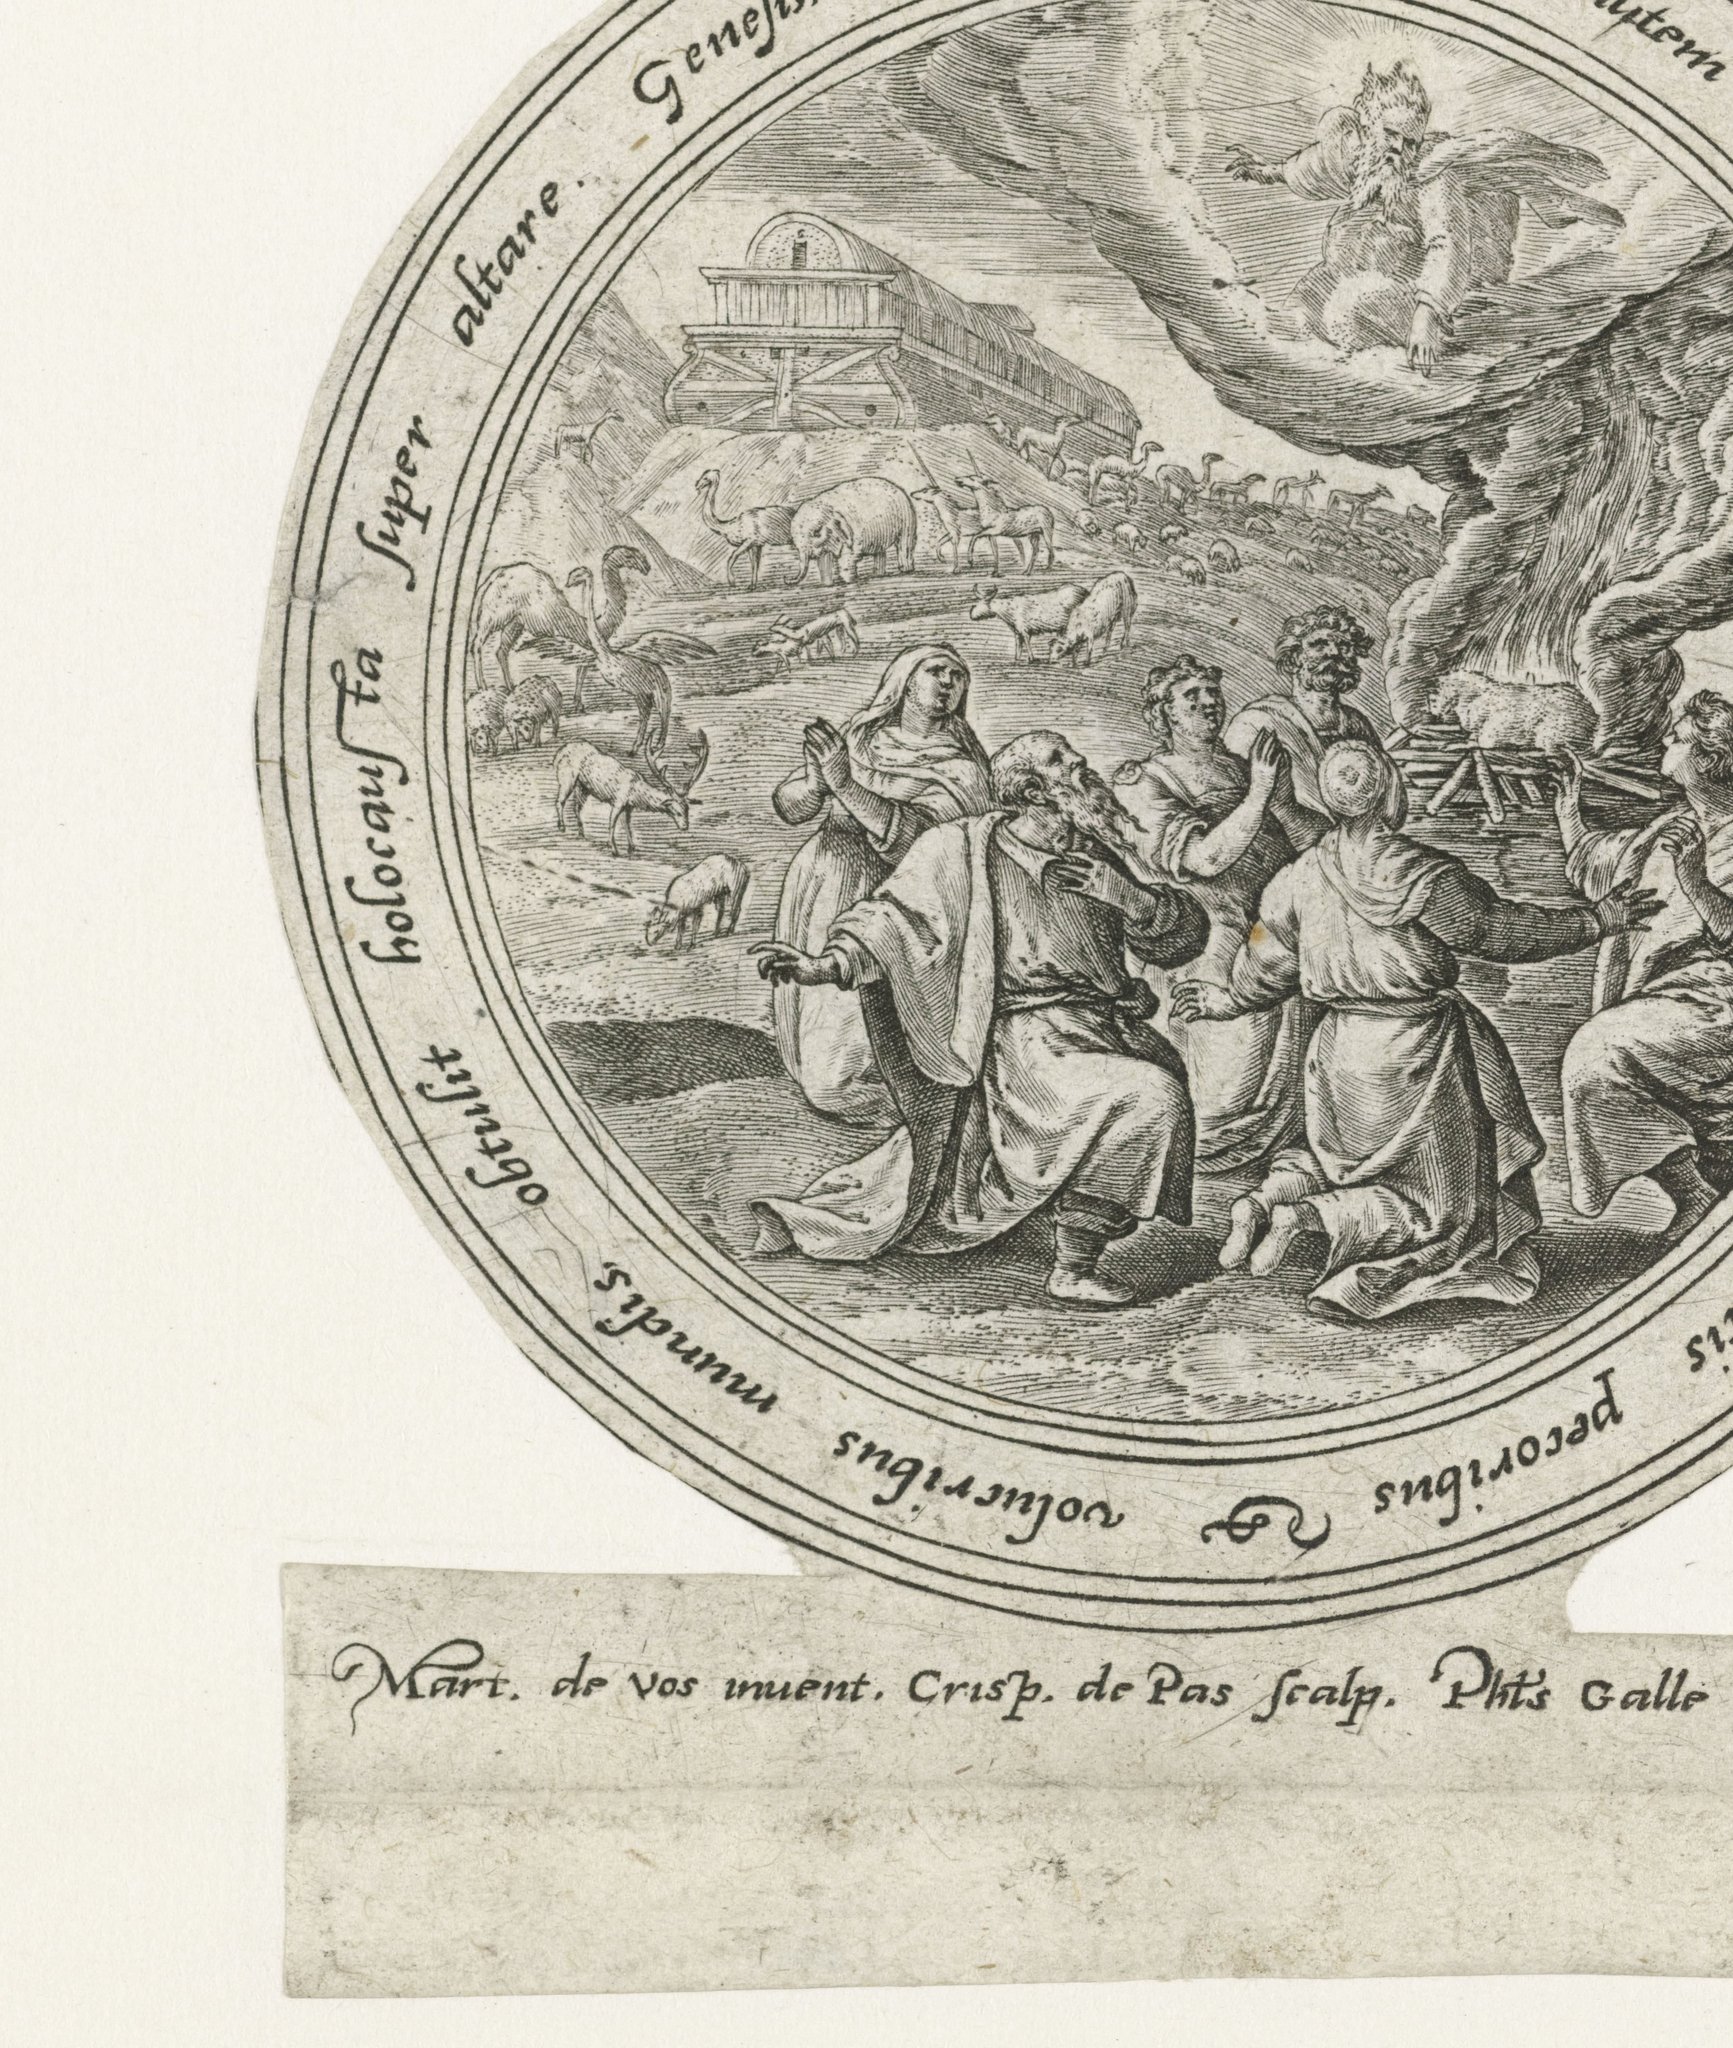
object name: print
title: Geschiedenis van Noach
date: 1580-1588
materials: paper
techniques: engraving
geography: antwerp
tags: noah's sacrifice; various animals are offered, possibly a lamb, a dove and a ram (often combined with the rainbow of the covenant)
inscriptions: inscription: ‘3.’, collector's mark: Lugt 2228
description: Noach en zijn familie zitten geknield voor een offeraltaar met daarop een lam. In de lucht God de Vader. Op de achtergrond staat op een heuvel de ark. Een stoet van dieren verlaat de ark. De voorstelling is gevat in een cirkelvormige omlijsting met een randschrift in het Latijn.